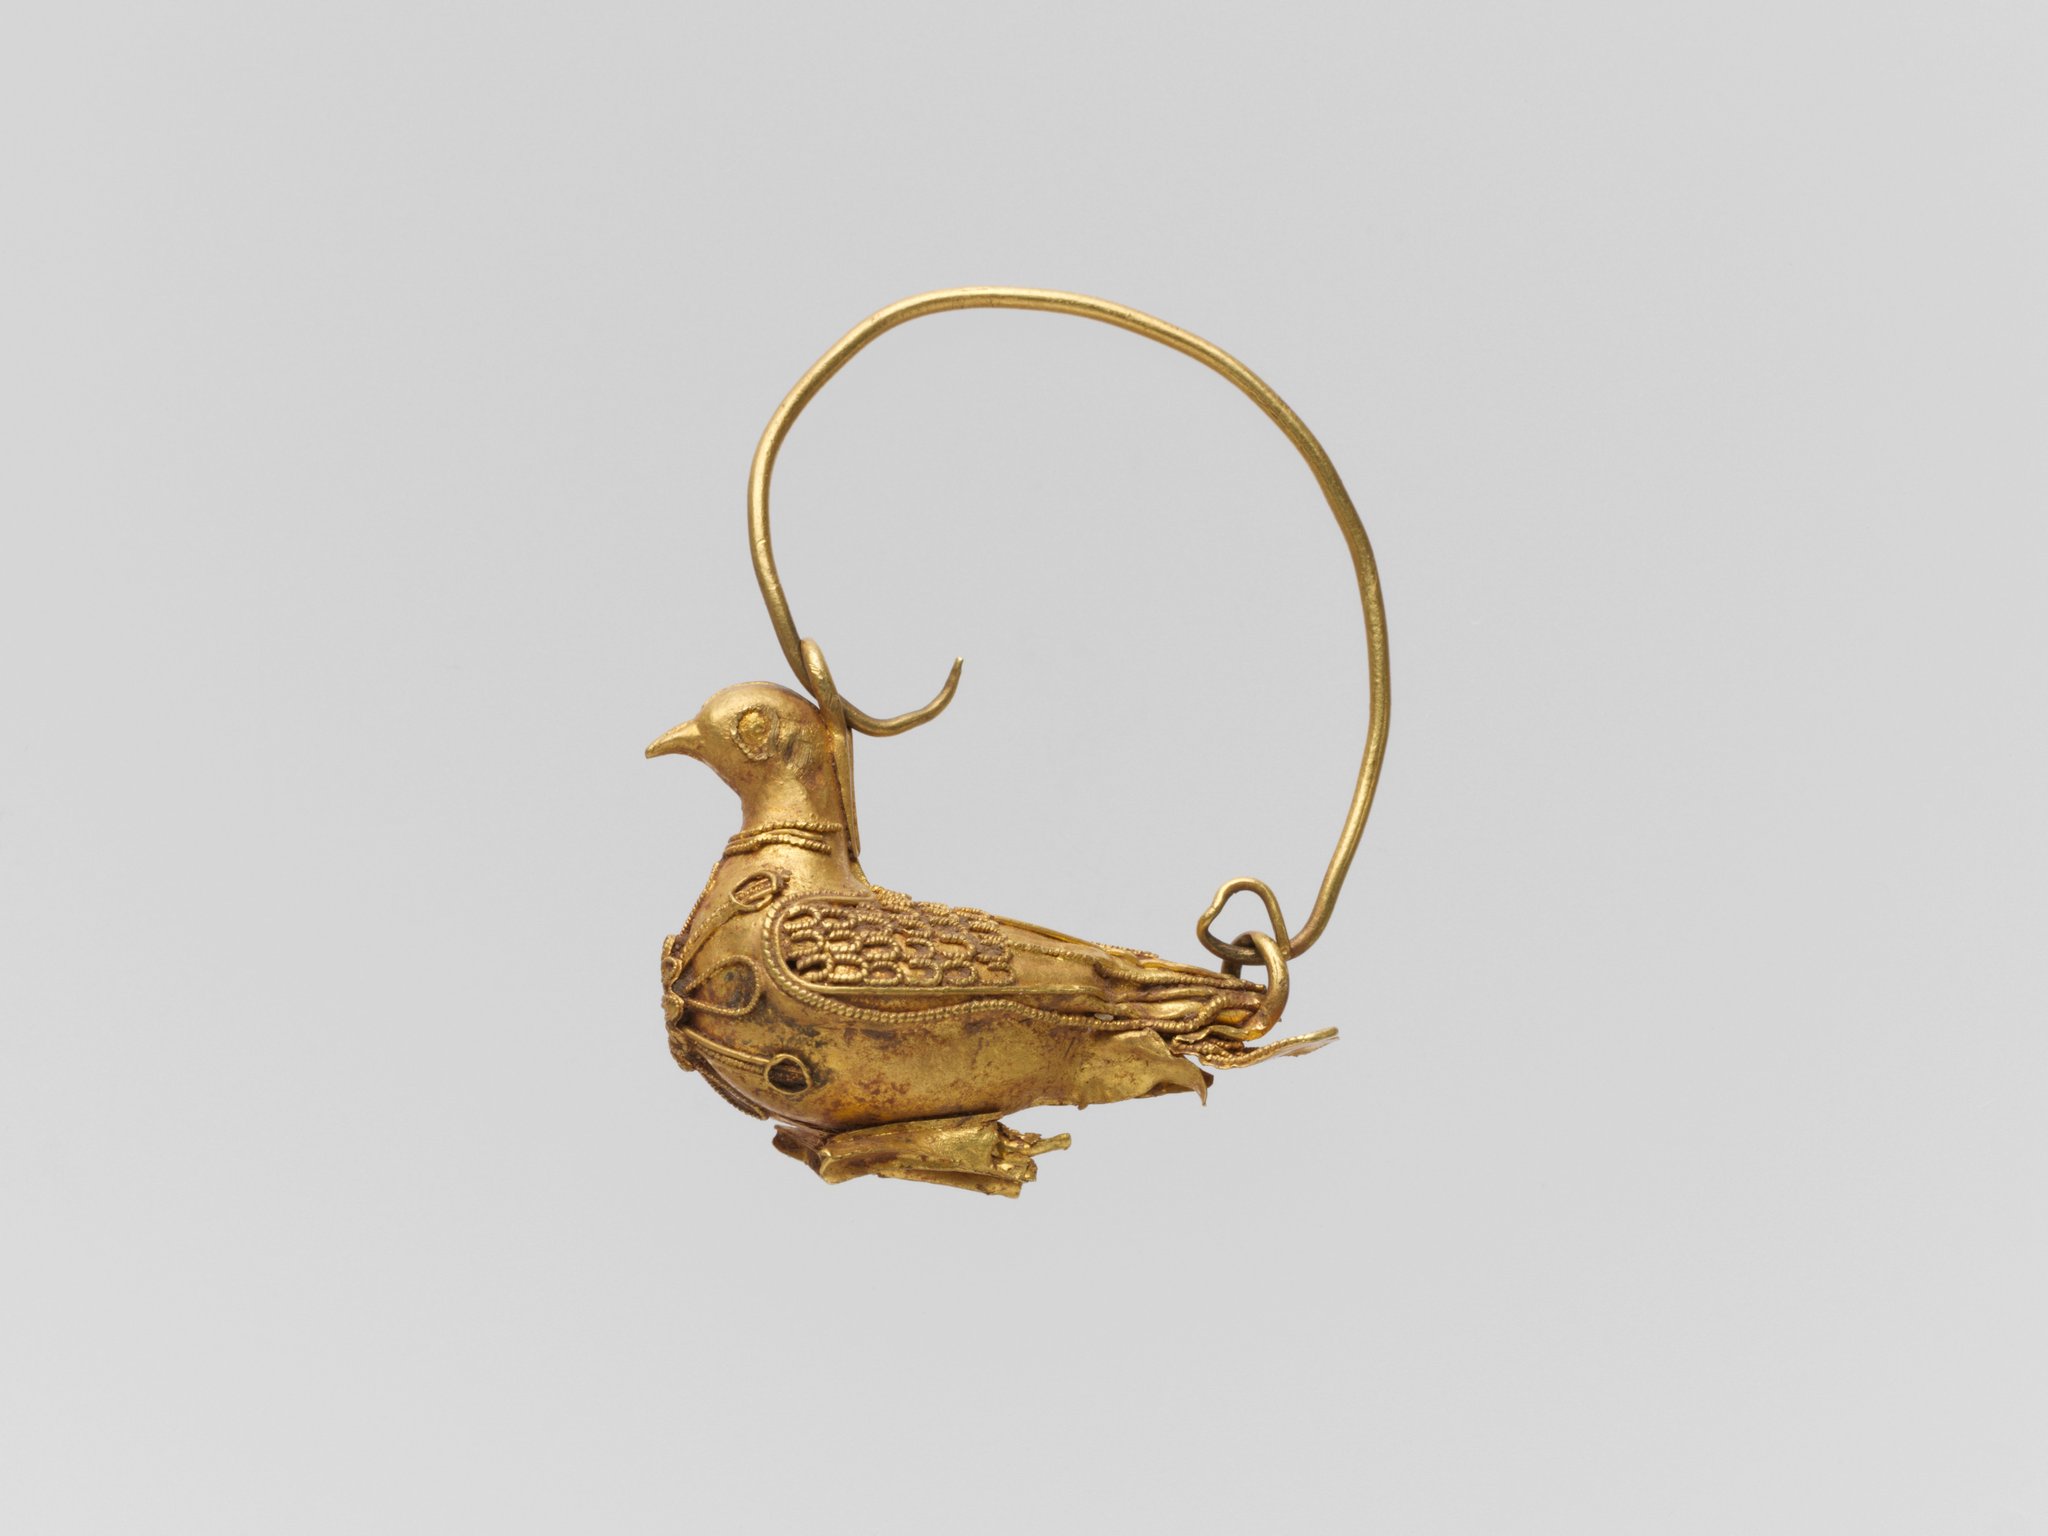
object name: earring with dove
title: Gold earring in the form of a dove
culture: greek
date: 200-101 BCE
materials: gold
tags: doves